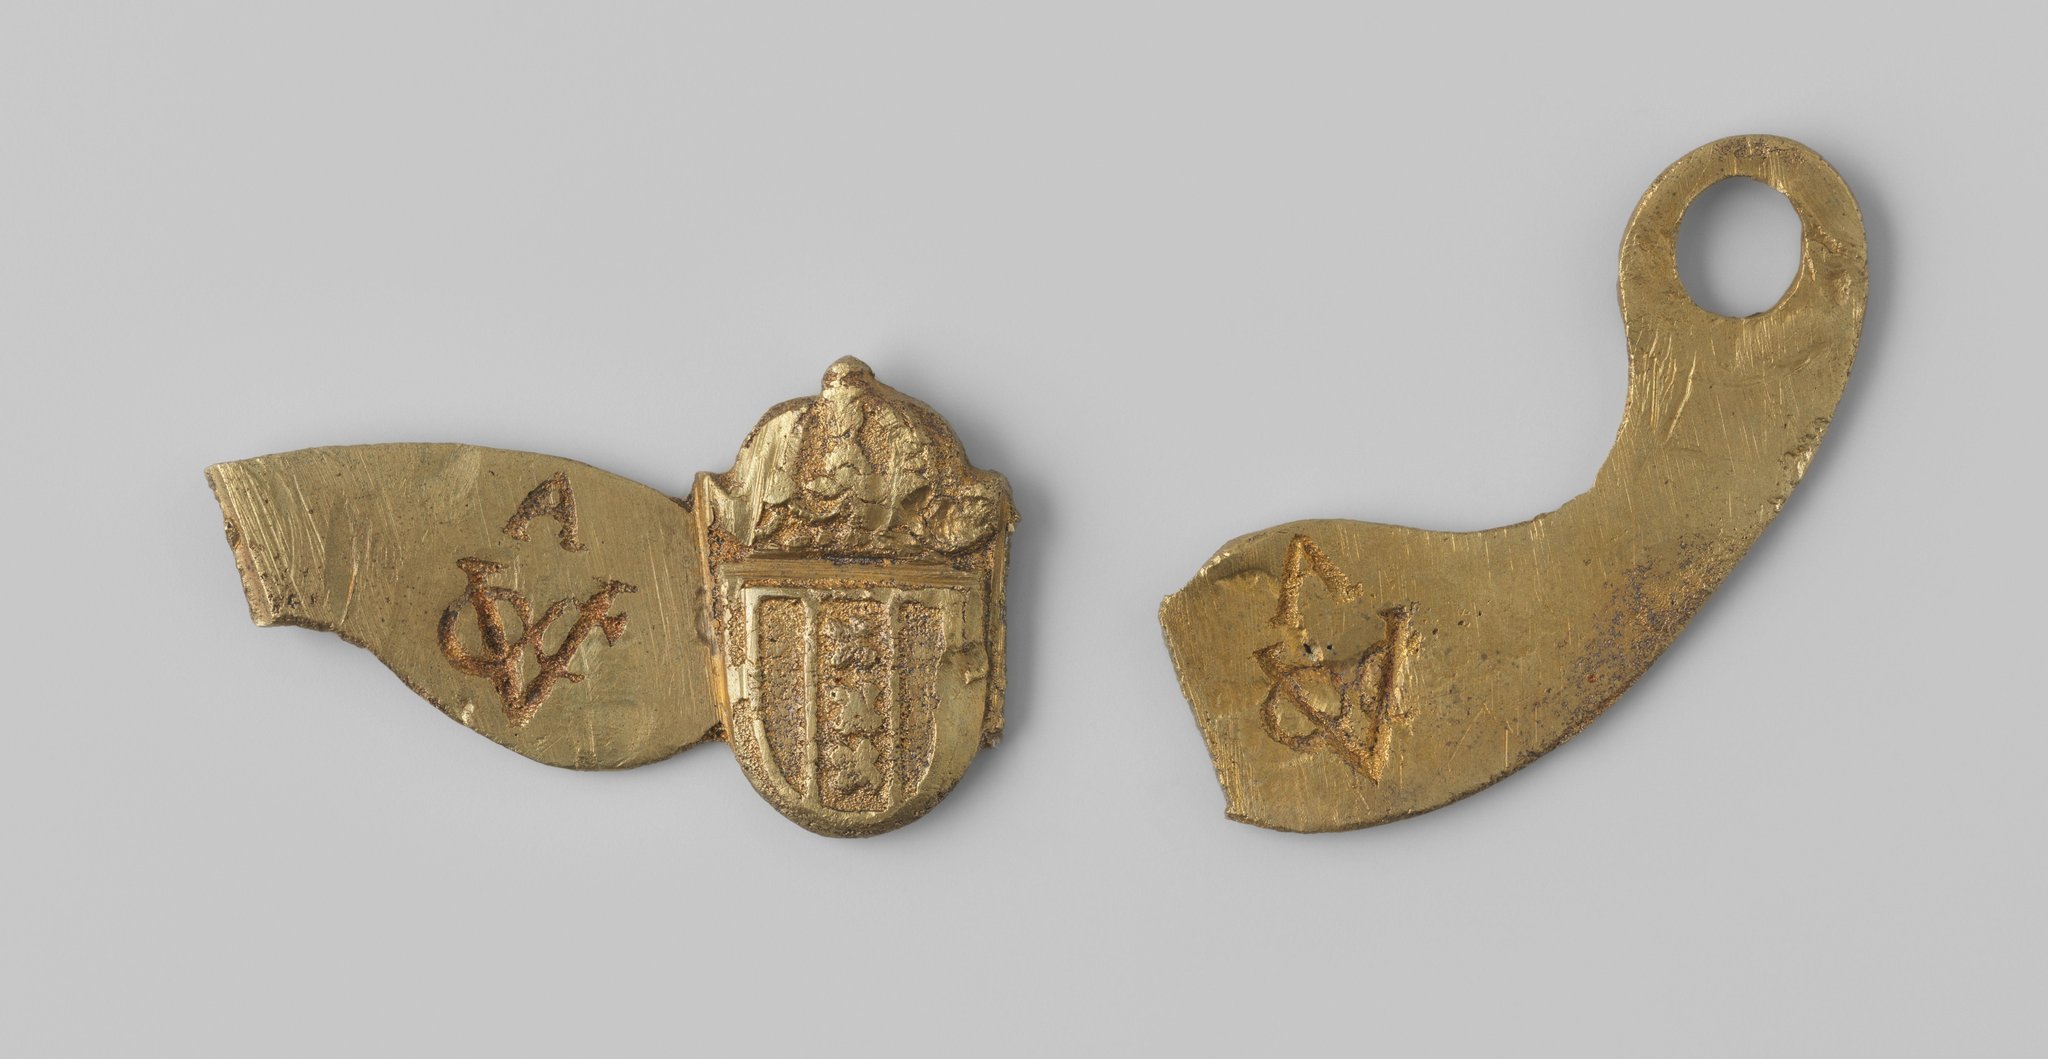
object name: schroefplaat, schroefblik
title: Fragmenten schroefplaat van een musket uit het wrak van de Oost-Indiëvaarder Hollandia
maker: Anonymous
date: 1700-1743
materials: copper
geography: netherlands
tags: verenigde oostindische compagnie, hollandia (schip), annet